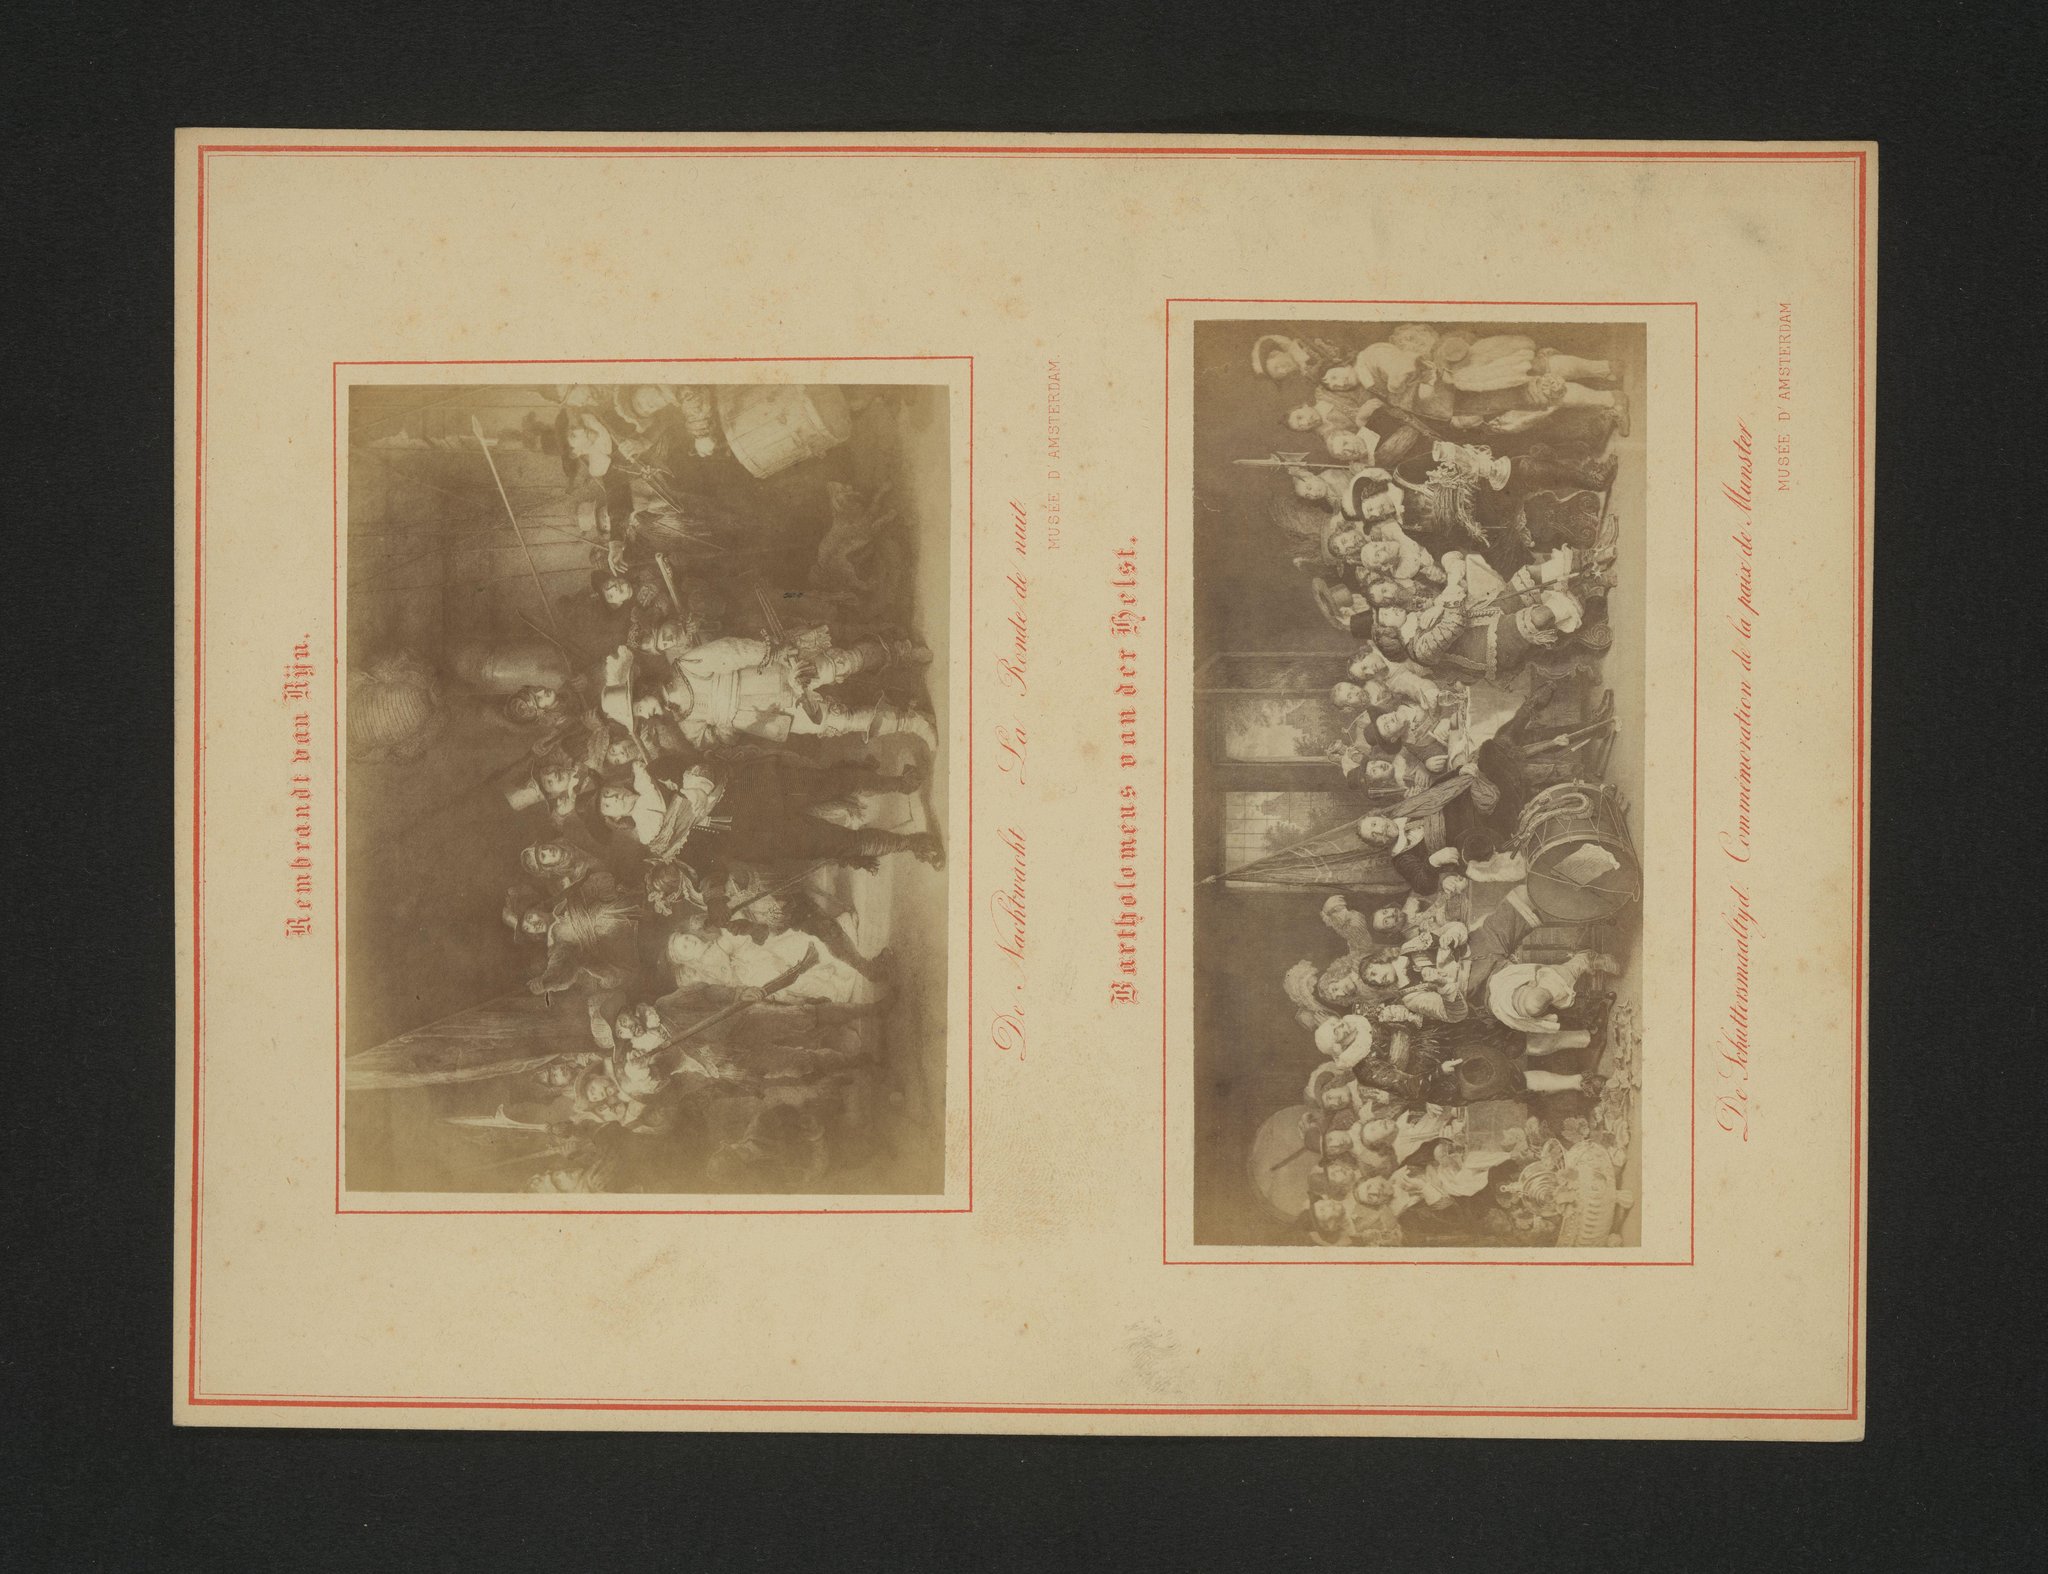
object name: reproduction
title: Rembrandt van Rijn - De nachtwacht, La ronde de nuit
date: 1866-1874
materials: cardboard, photographic support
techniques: albumen print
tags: historical persons, girl (child between toddler and youth), weapons, warfare; military affairs (+ citizen soldiery, civil guard, citizen militia), celebration meal, feast, banquet, (military) flags and standards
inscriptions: annotation: ‘Musée d'Amsterdam’, annotation: ‘Musée d'Amsterdam’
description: Deze foto maakt deel uit van een omslag met 25 foto's.